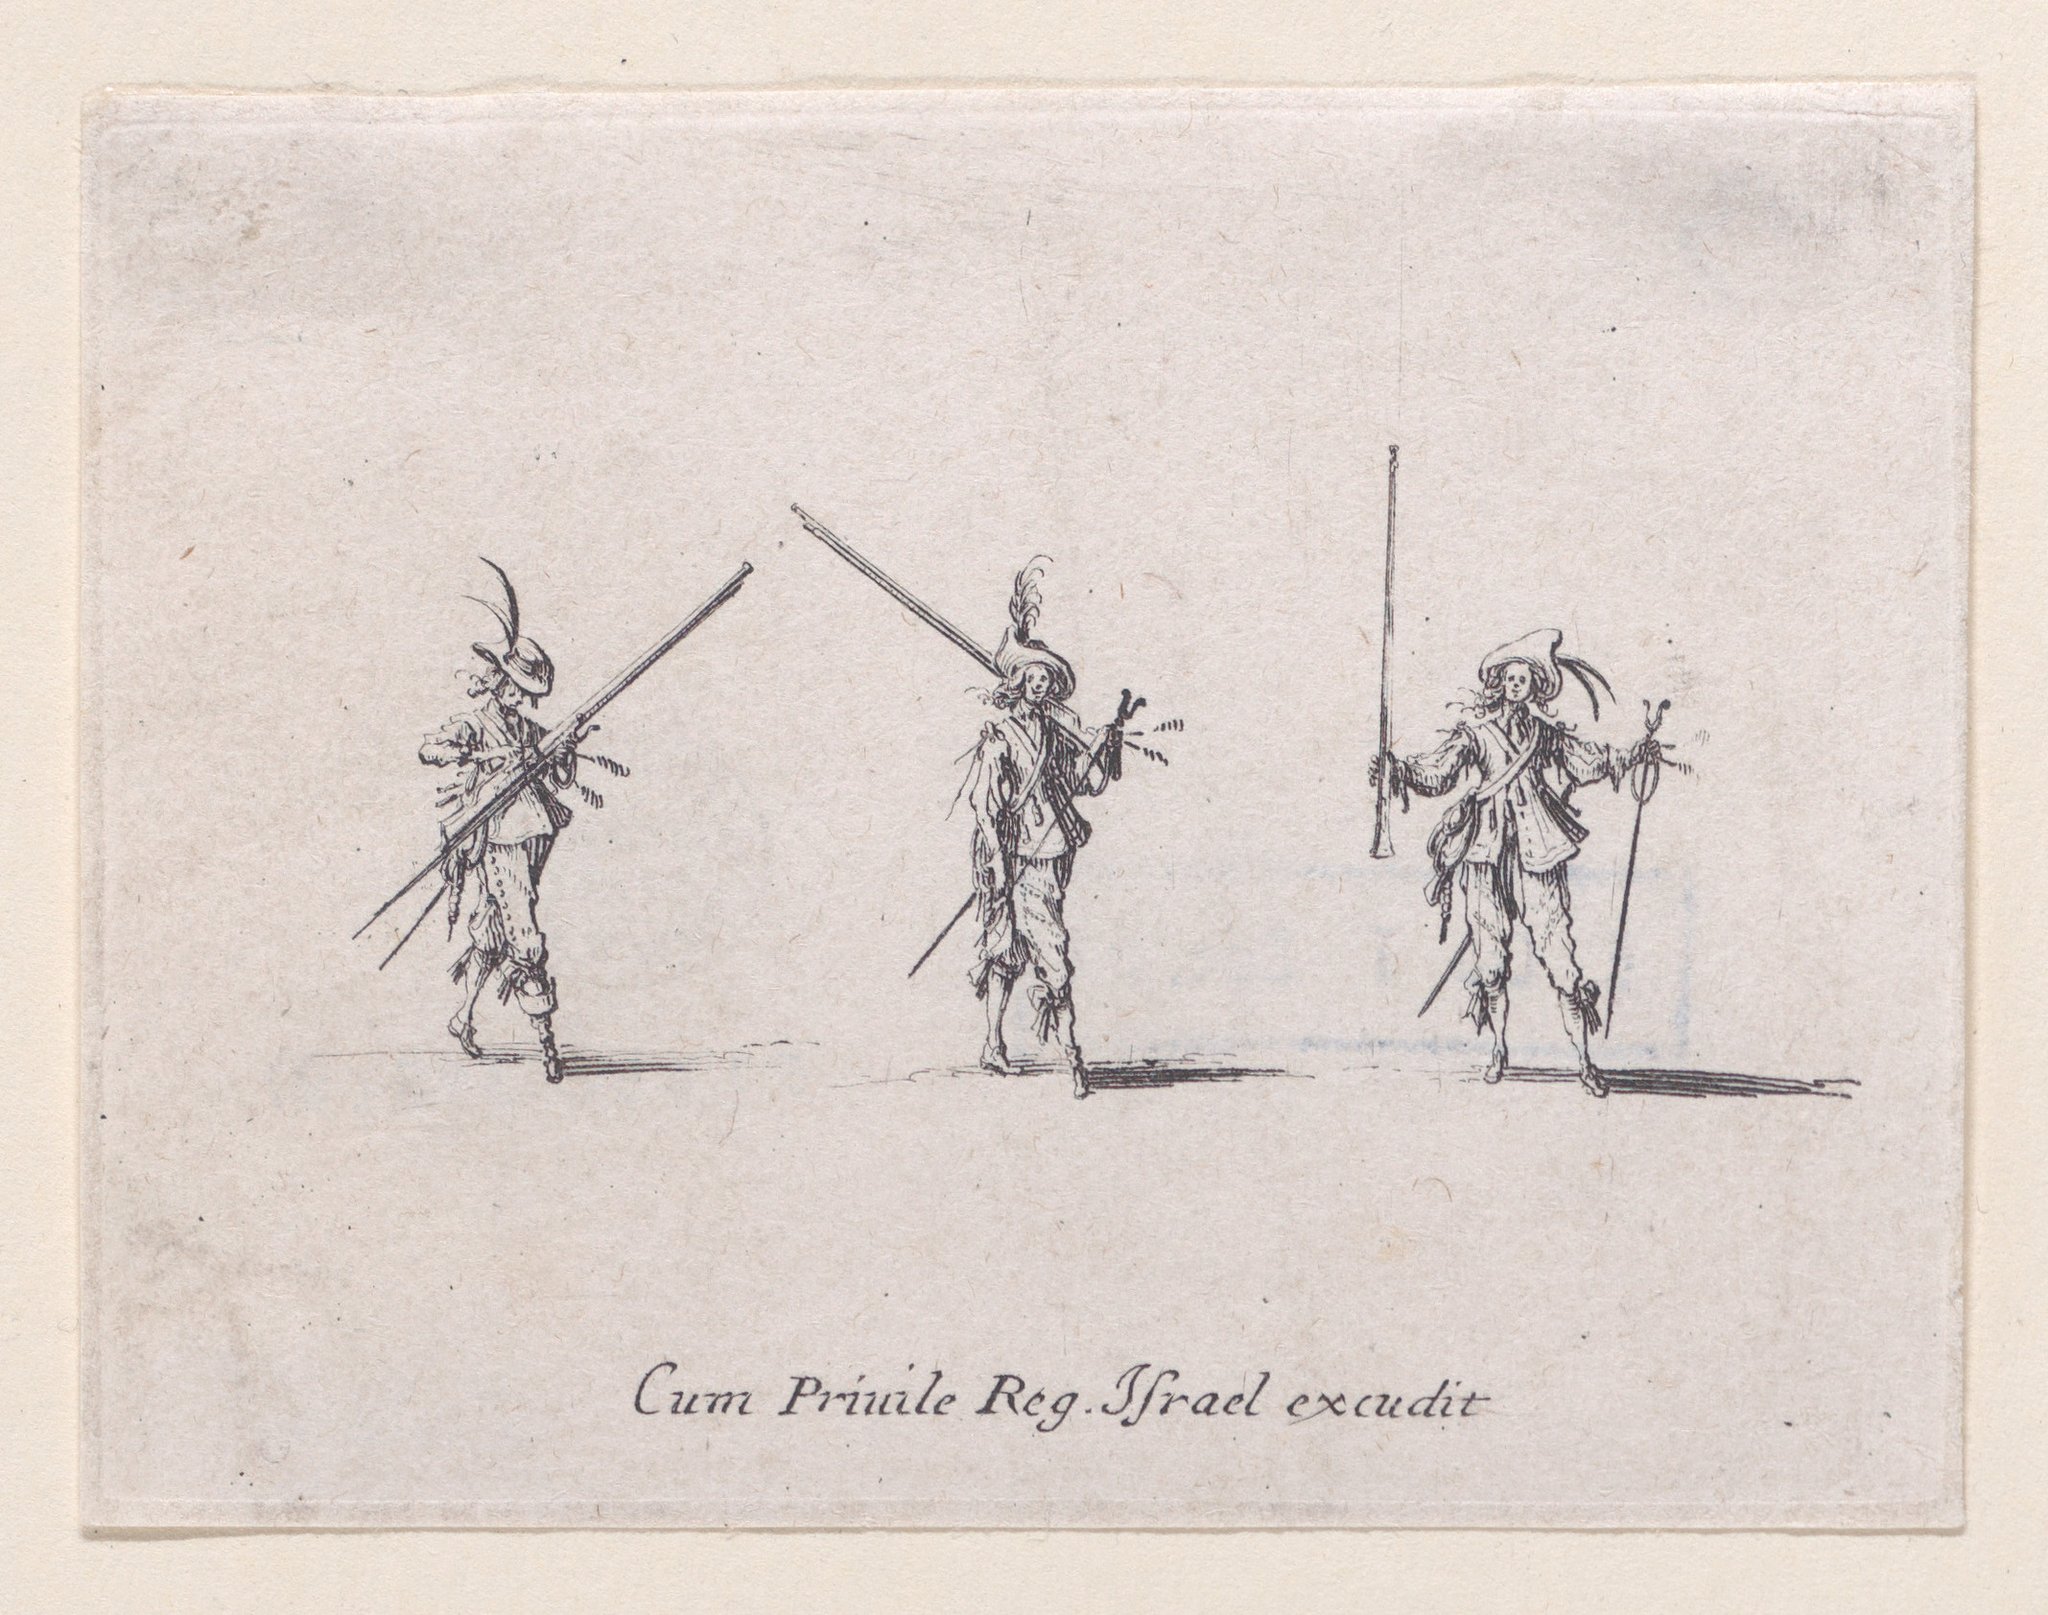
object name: print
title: L'Exercice de L'Arquebuse: Le Chargement (Drill of the Arquebus: The Loading), from "Les Exercices Militaires" (The Military Exercises)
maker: jacques callot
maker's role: artist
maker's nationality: french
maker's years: 1592-1635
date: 1635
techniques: etching